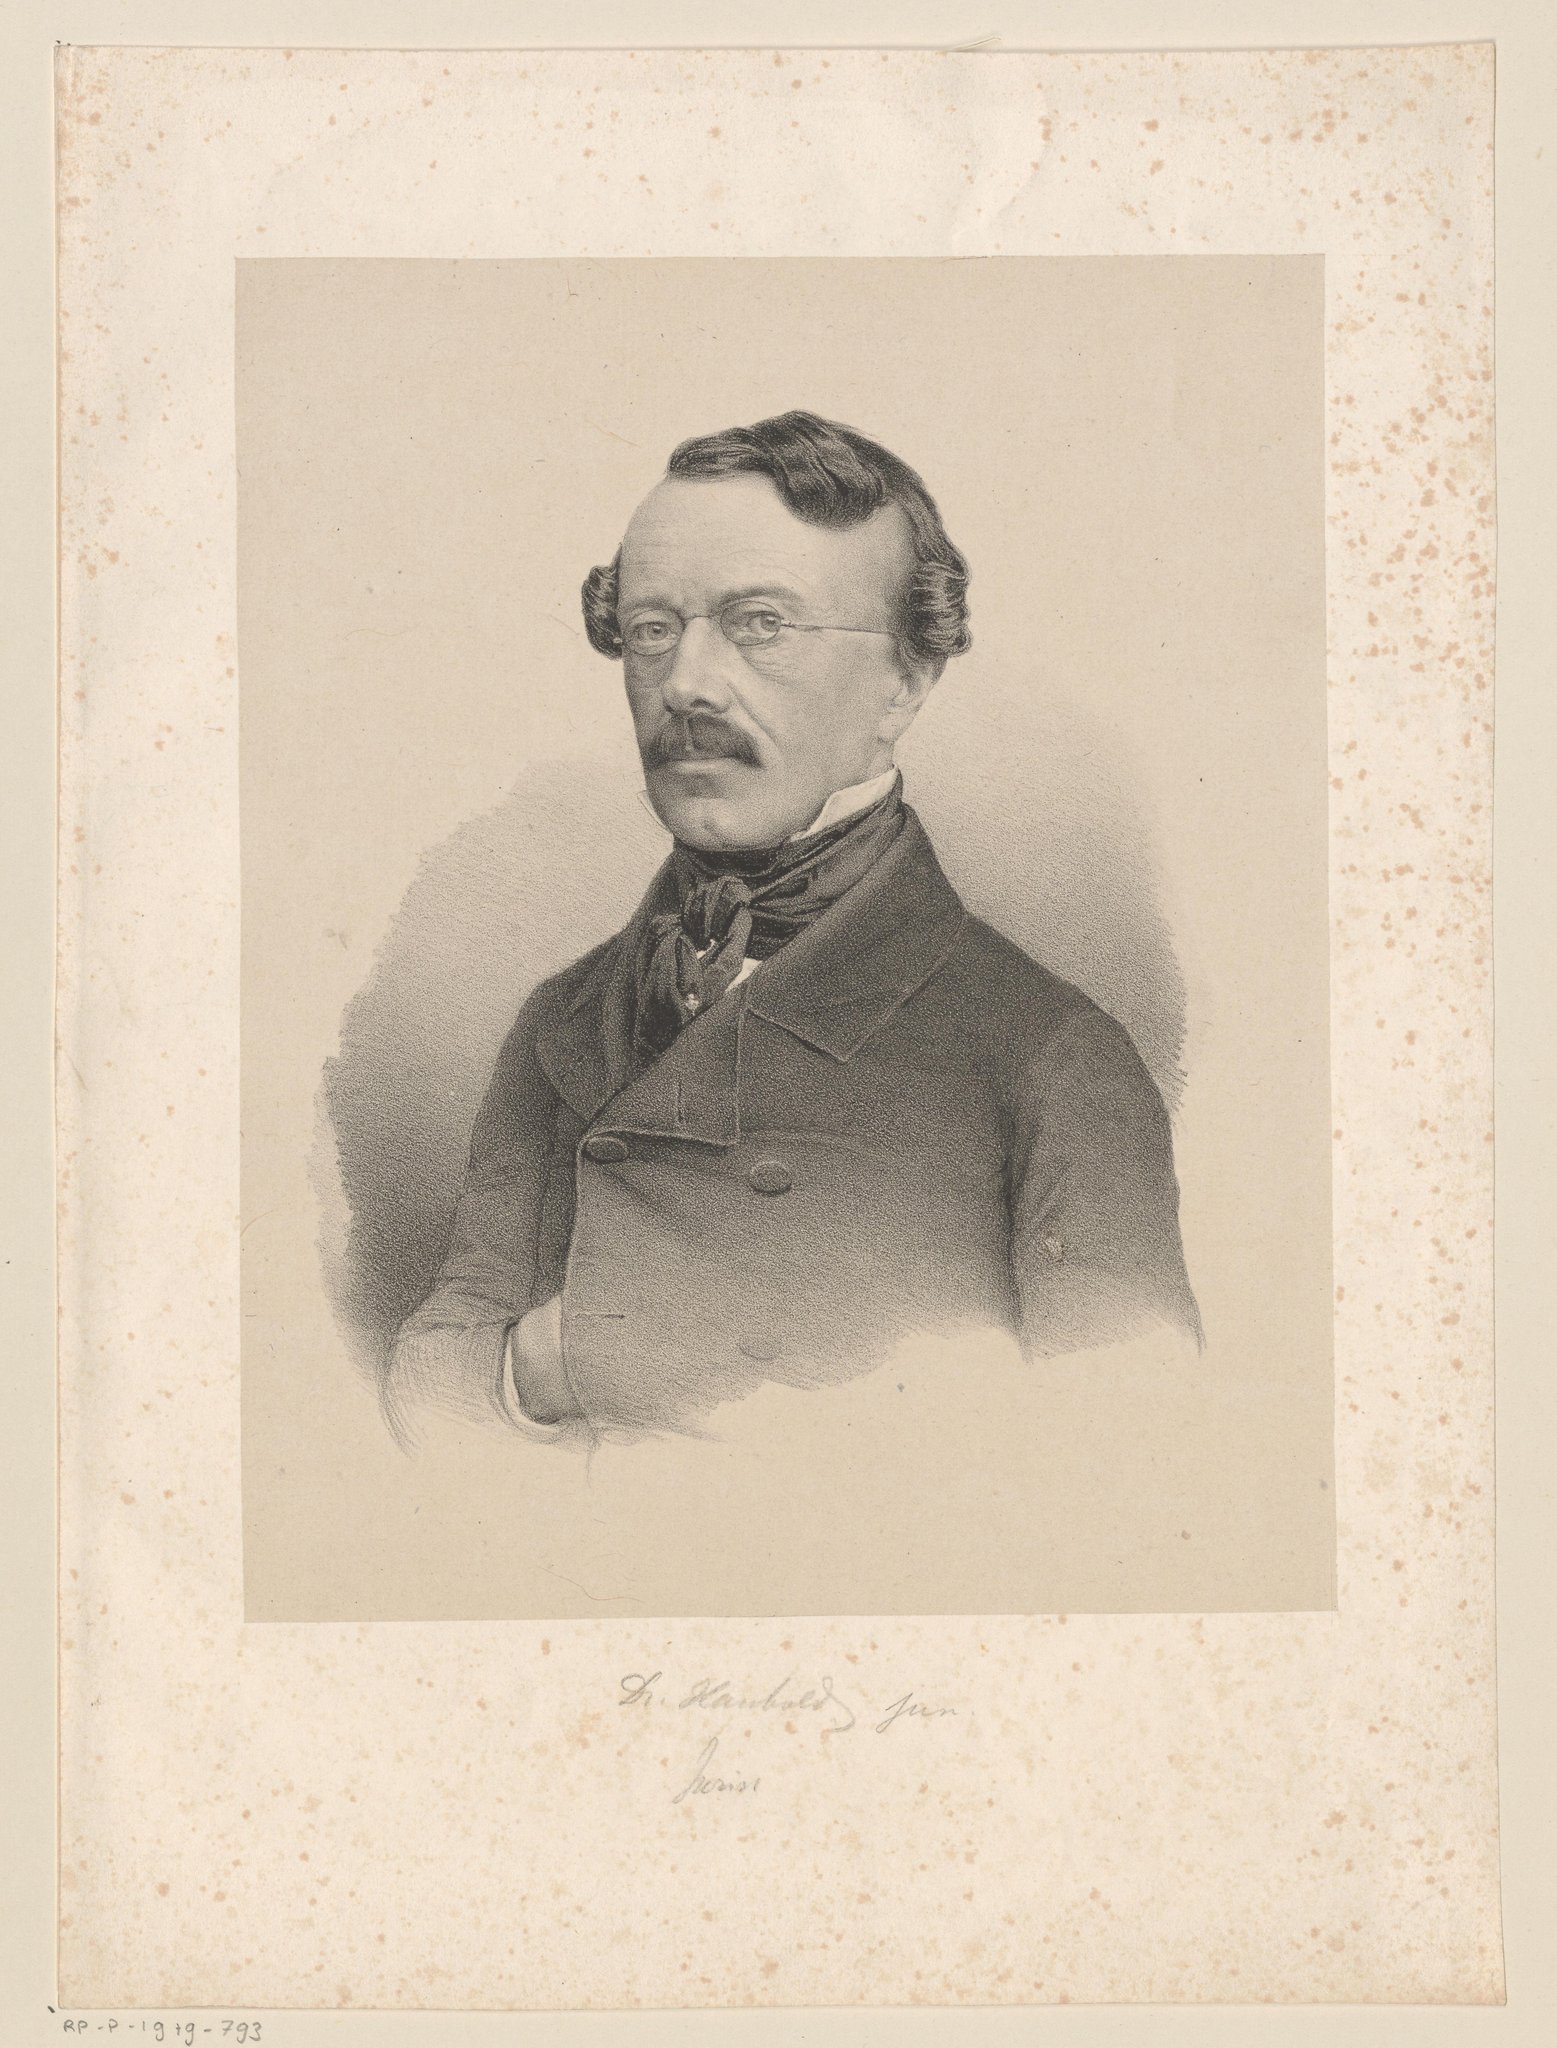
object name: print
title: Portret van een man, aangeduid als Dr. Haubold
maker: Anonymous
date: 1825-1874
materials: paper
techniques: lithograph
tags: eyeglasses, spectacles, historical persons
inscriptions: collector's mark: Lugt 2228